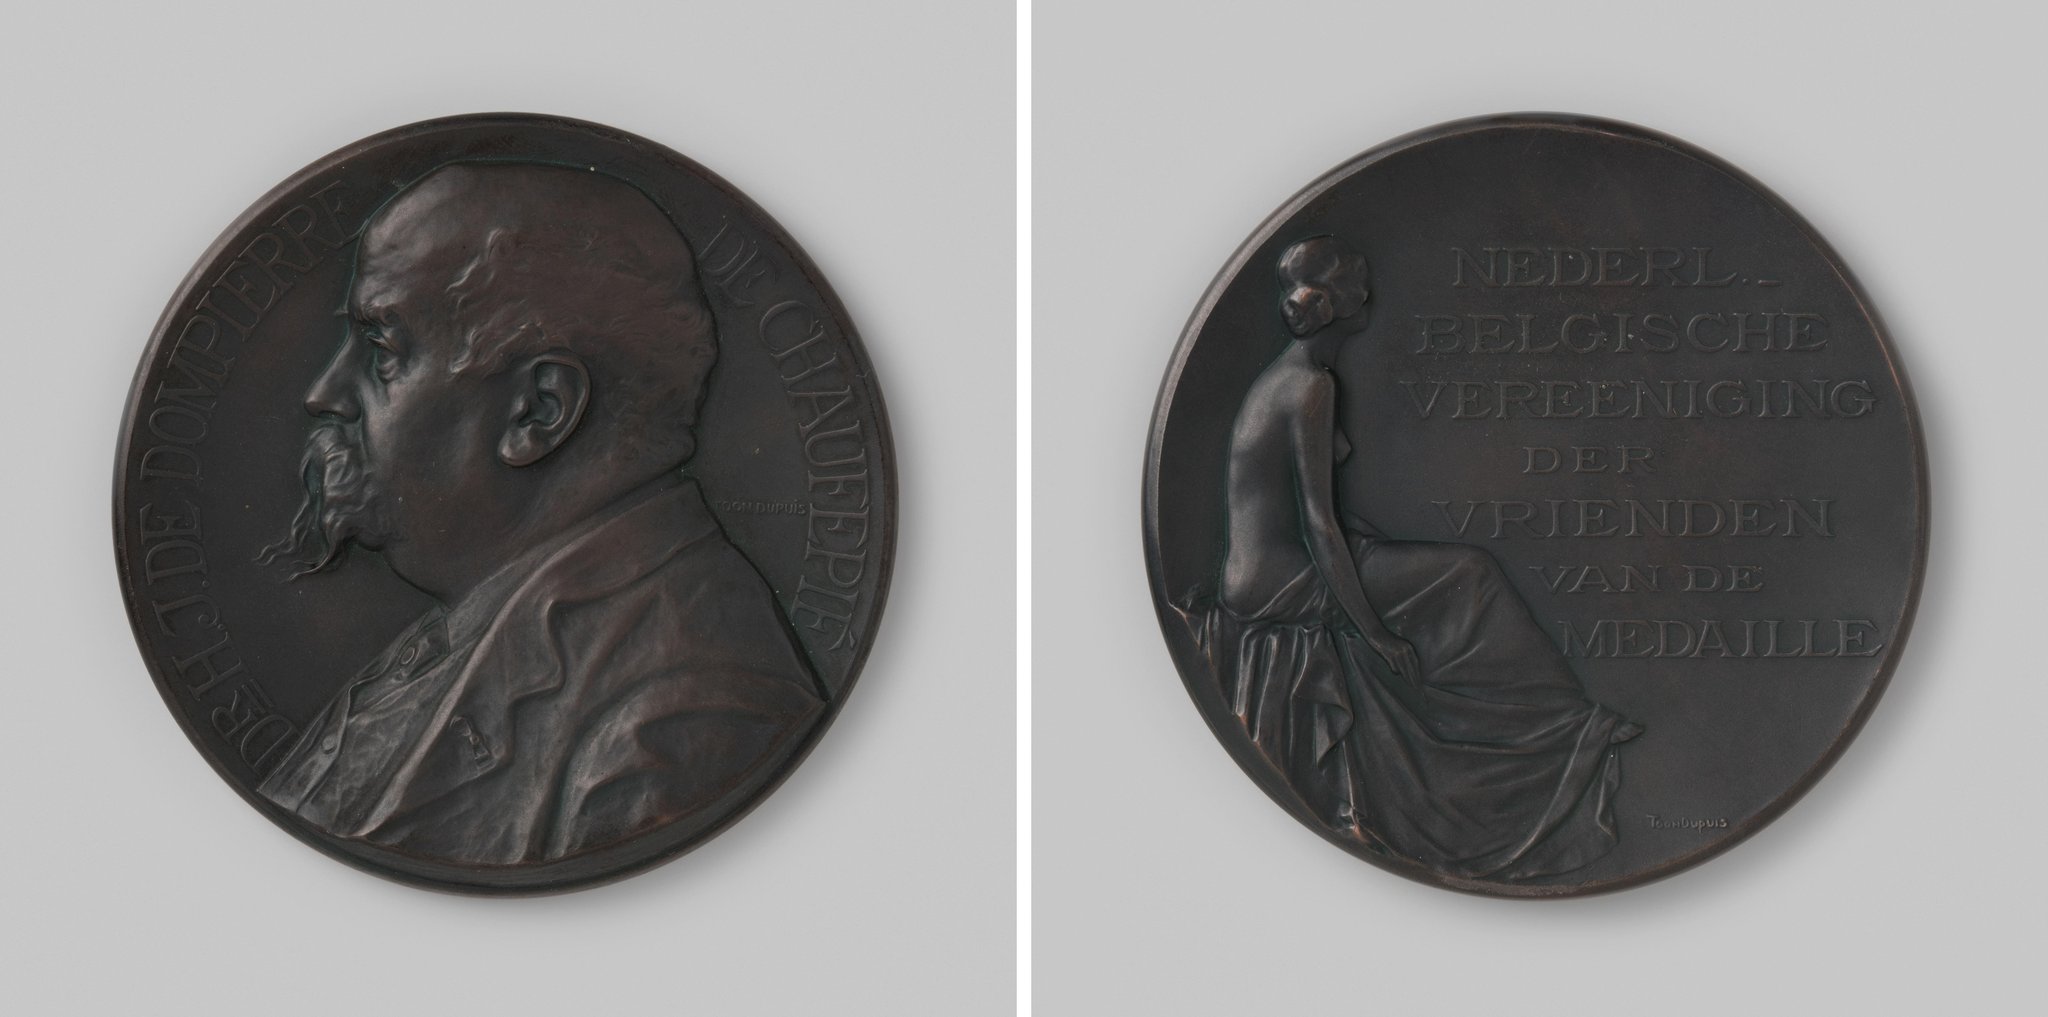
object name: history medal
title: H.J. de Dompierre de Chaufepié 1908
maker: toon dupuis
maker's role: sculptor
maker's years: 1877-1937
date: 1908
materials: copper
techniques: striking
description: Verzilverde penning, op de voorzijde het borstbeeld van De Dompierre naar links met omschrift, op de keerzijde een zittende vrouw met rechts zeven regels tekst.